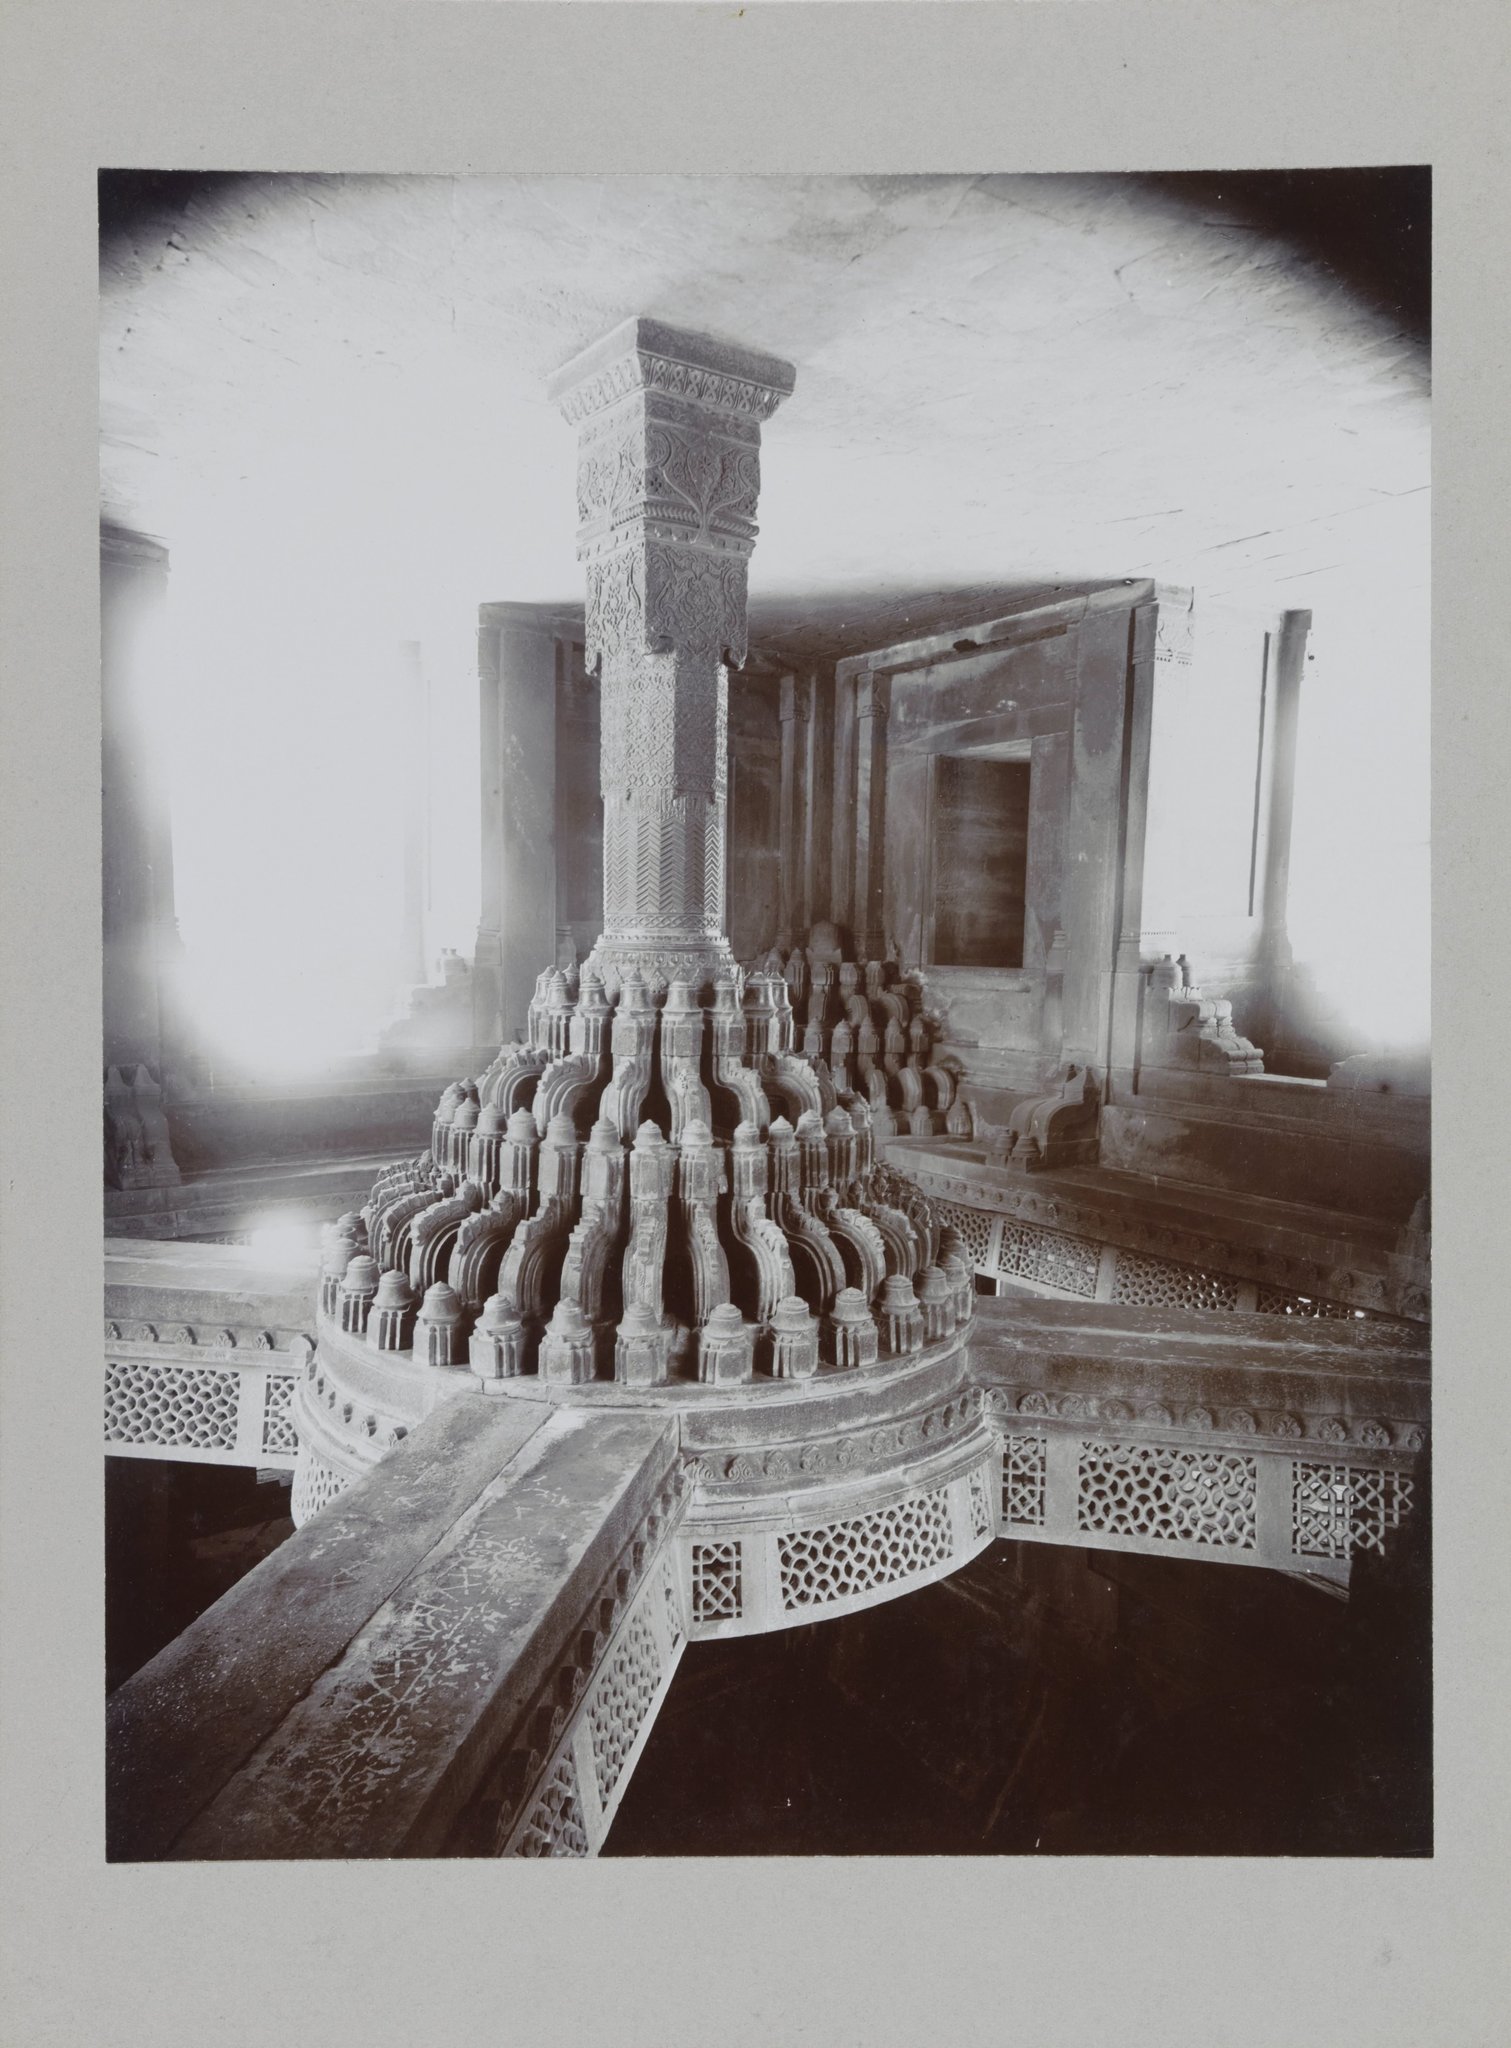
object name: photograph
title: Decorated column in the Diwan-i-Khas at Fatehpur Sikri, Uttar Pradesh, India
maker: Anonymous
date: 1895-1915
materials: cardboard, paper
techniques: gelatin silver print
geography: fatehpur sikri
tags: fatehpur sikri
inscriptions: annotation: ‘47. Zuil in de ontvangzaal te Tatehpur-Sikri.’